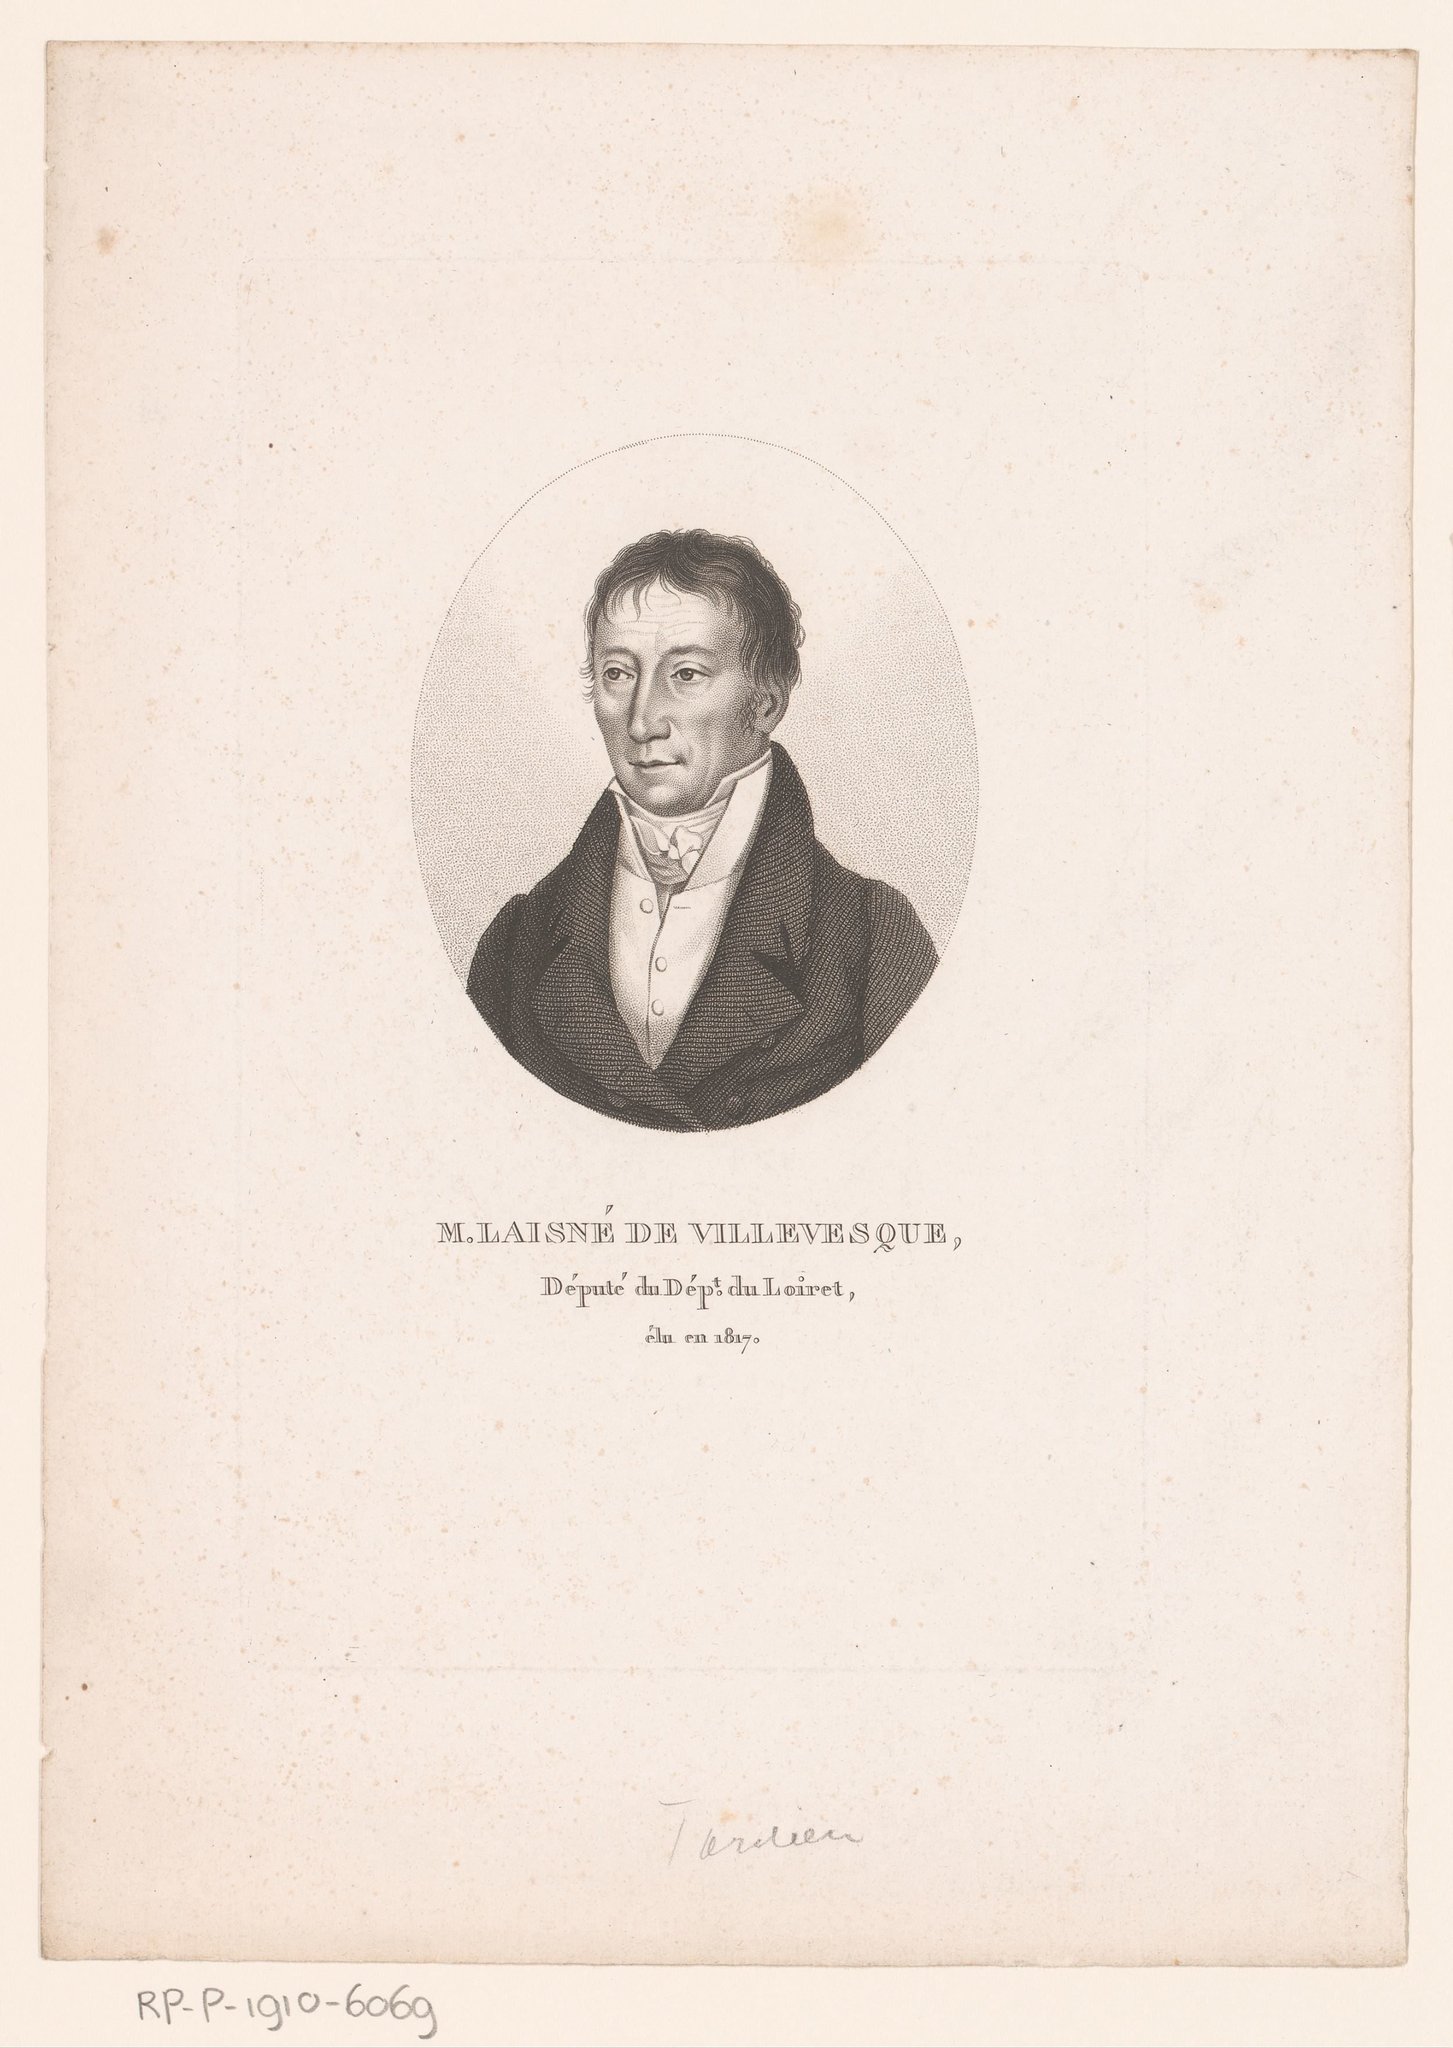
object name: print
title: Portret van Gabriel-Jacques Laisné de Villévêque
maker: ambroise tardieu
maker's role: print maker, printer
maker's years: 1788-1841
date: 1820-1821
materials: paper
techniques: engraving, roulette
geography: paris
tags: politician, historical persons, politician, e.g. party leader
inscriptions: collector's mark: Lugt 2228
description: Prent uit: Tardieu, Ambroise. Portraits des députés, écrivains et pairs constitutionnels, défenseurs invariables de la charte et de la loi des élections du 5 février 1817. Parijs: Tardieu, Ambroise, 1820-1821.